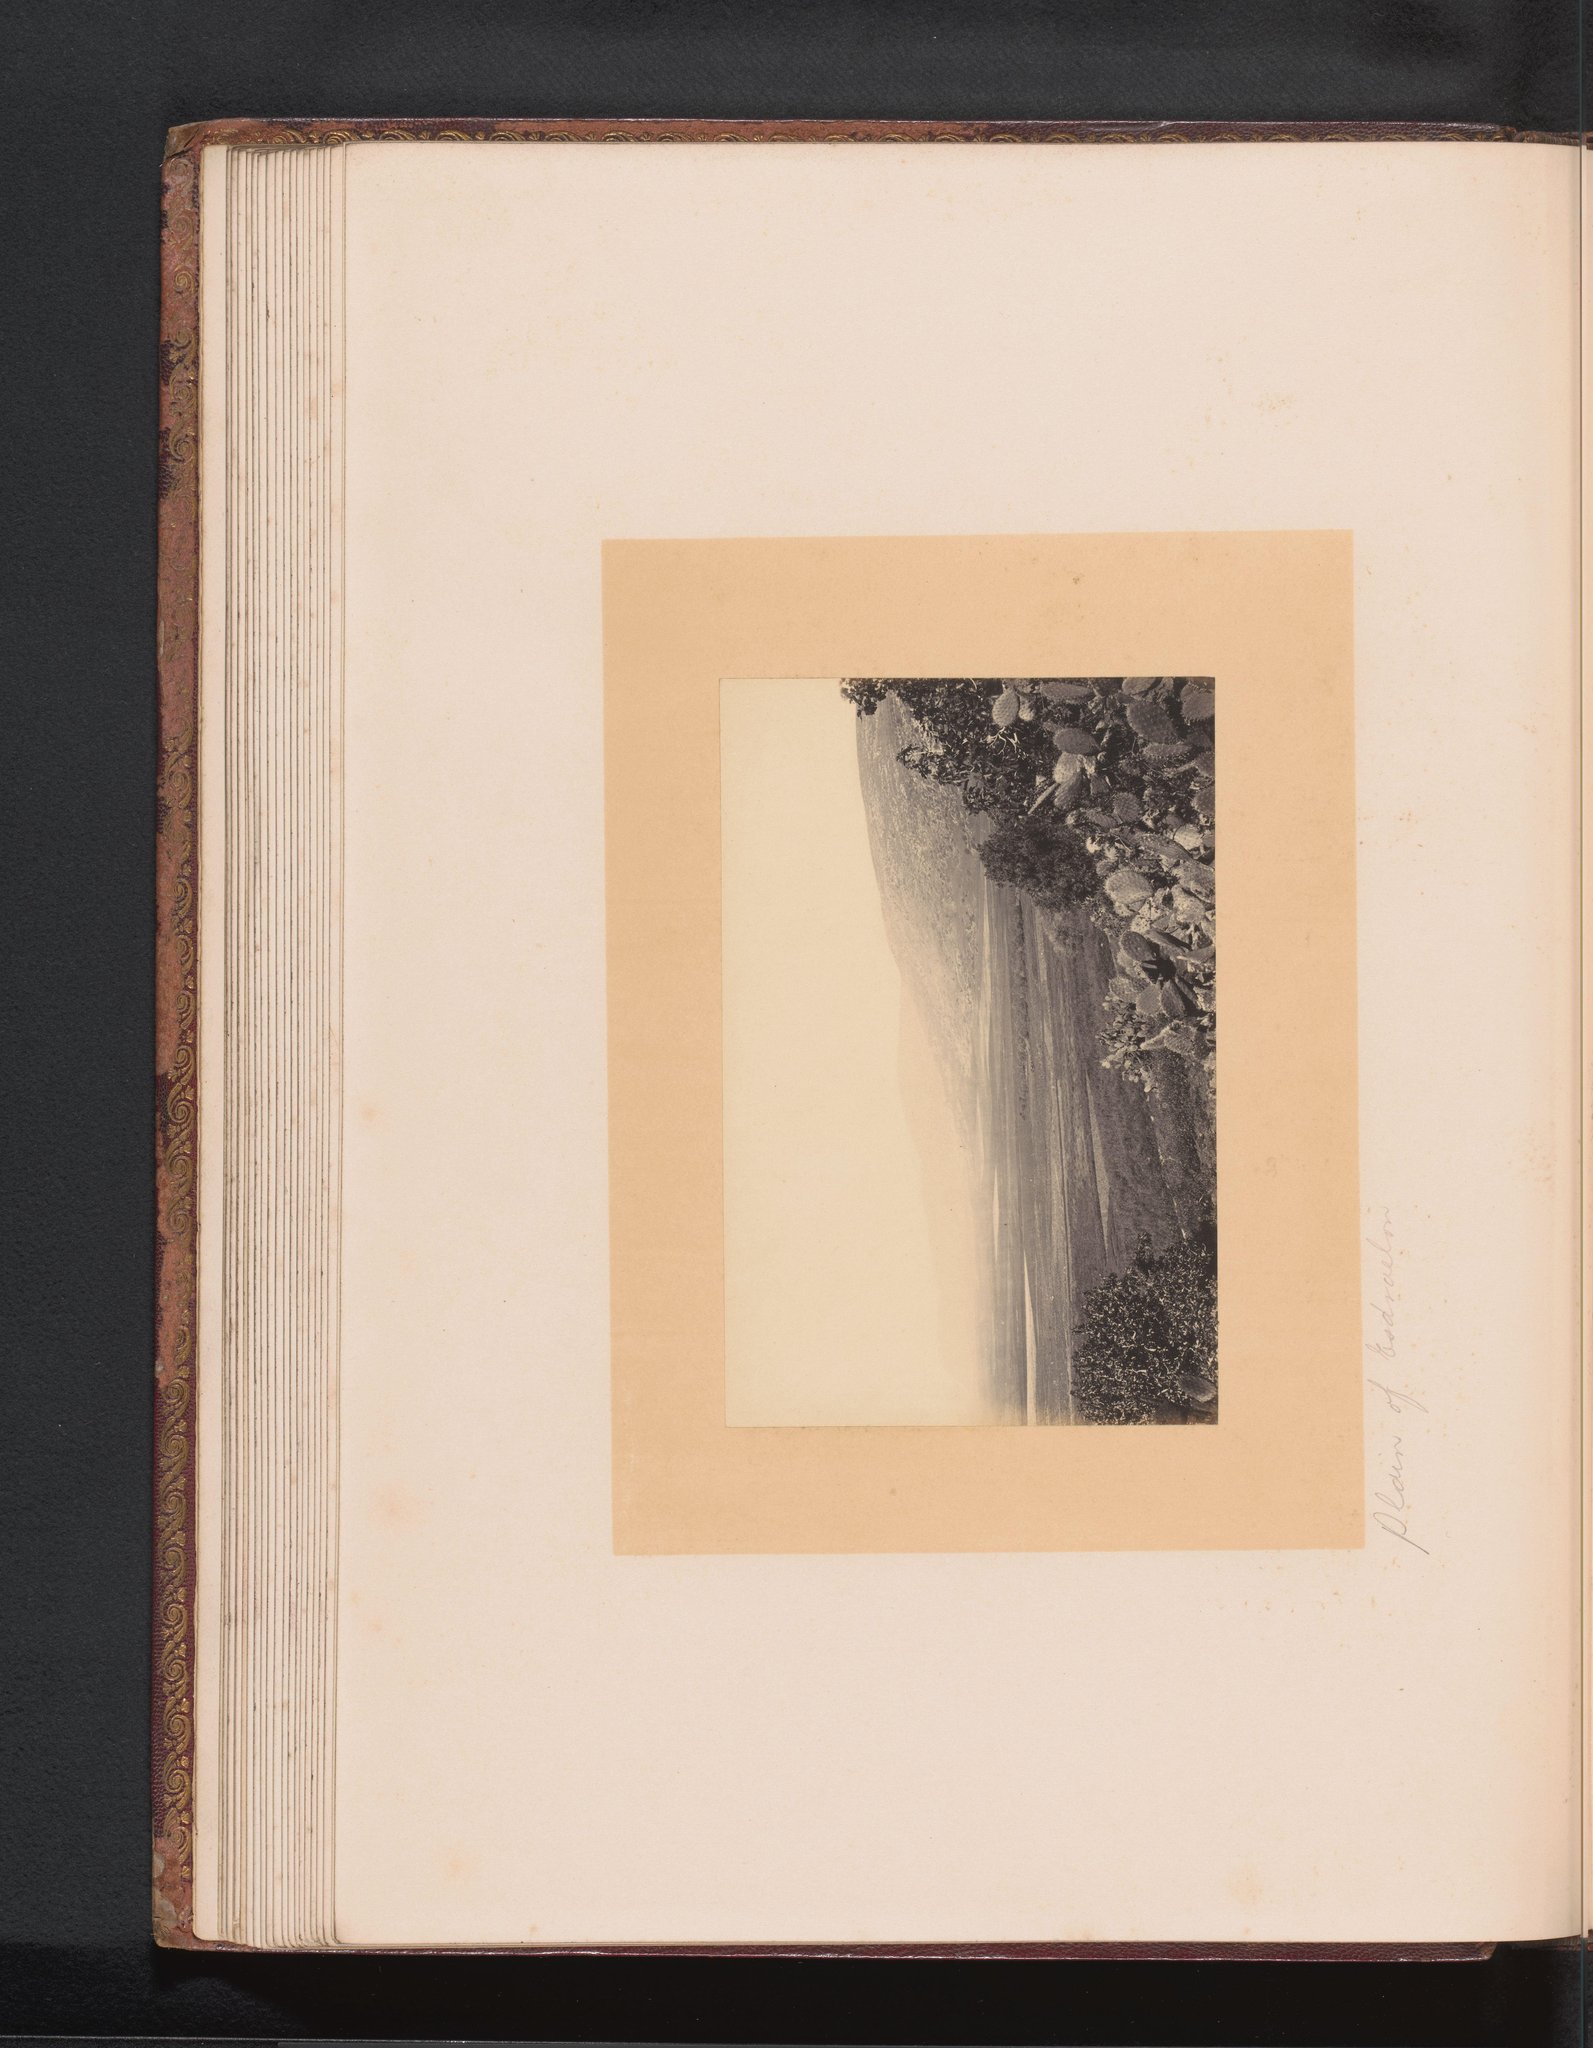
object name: page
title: Gezicht op de vlakte van Jizreël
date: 1870-1875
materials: photographic support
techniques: albumen print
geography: jizreël, vlakte van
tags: plain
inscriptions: annotation: ‘Plain of Esdaelon’